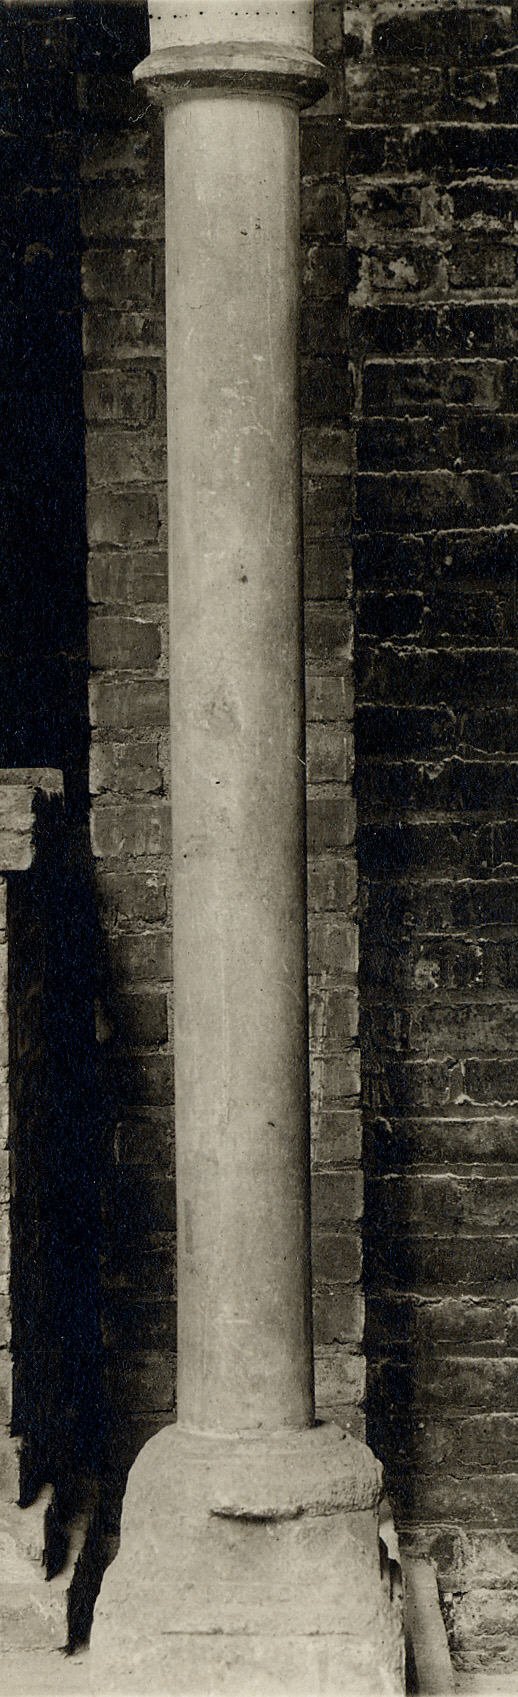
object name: shaft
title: Column Shaft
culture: french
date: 1267-1333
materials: stone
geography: france